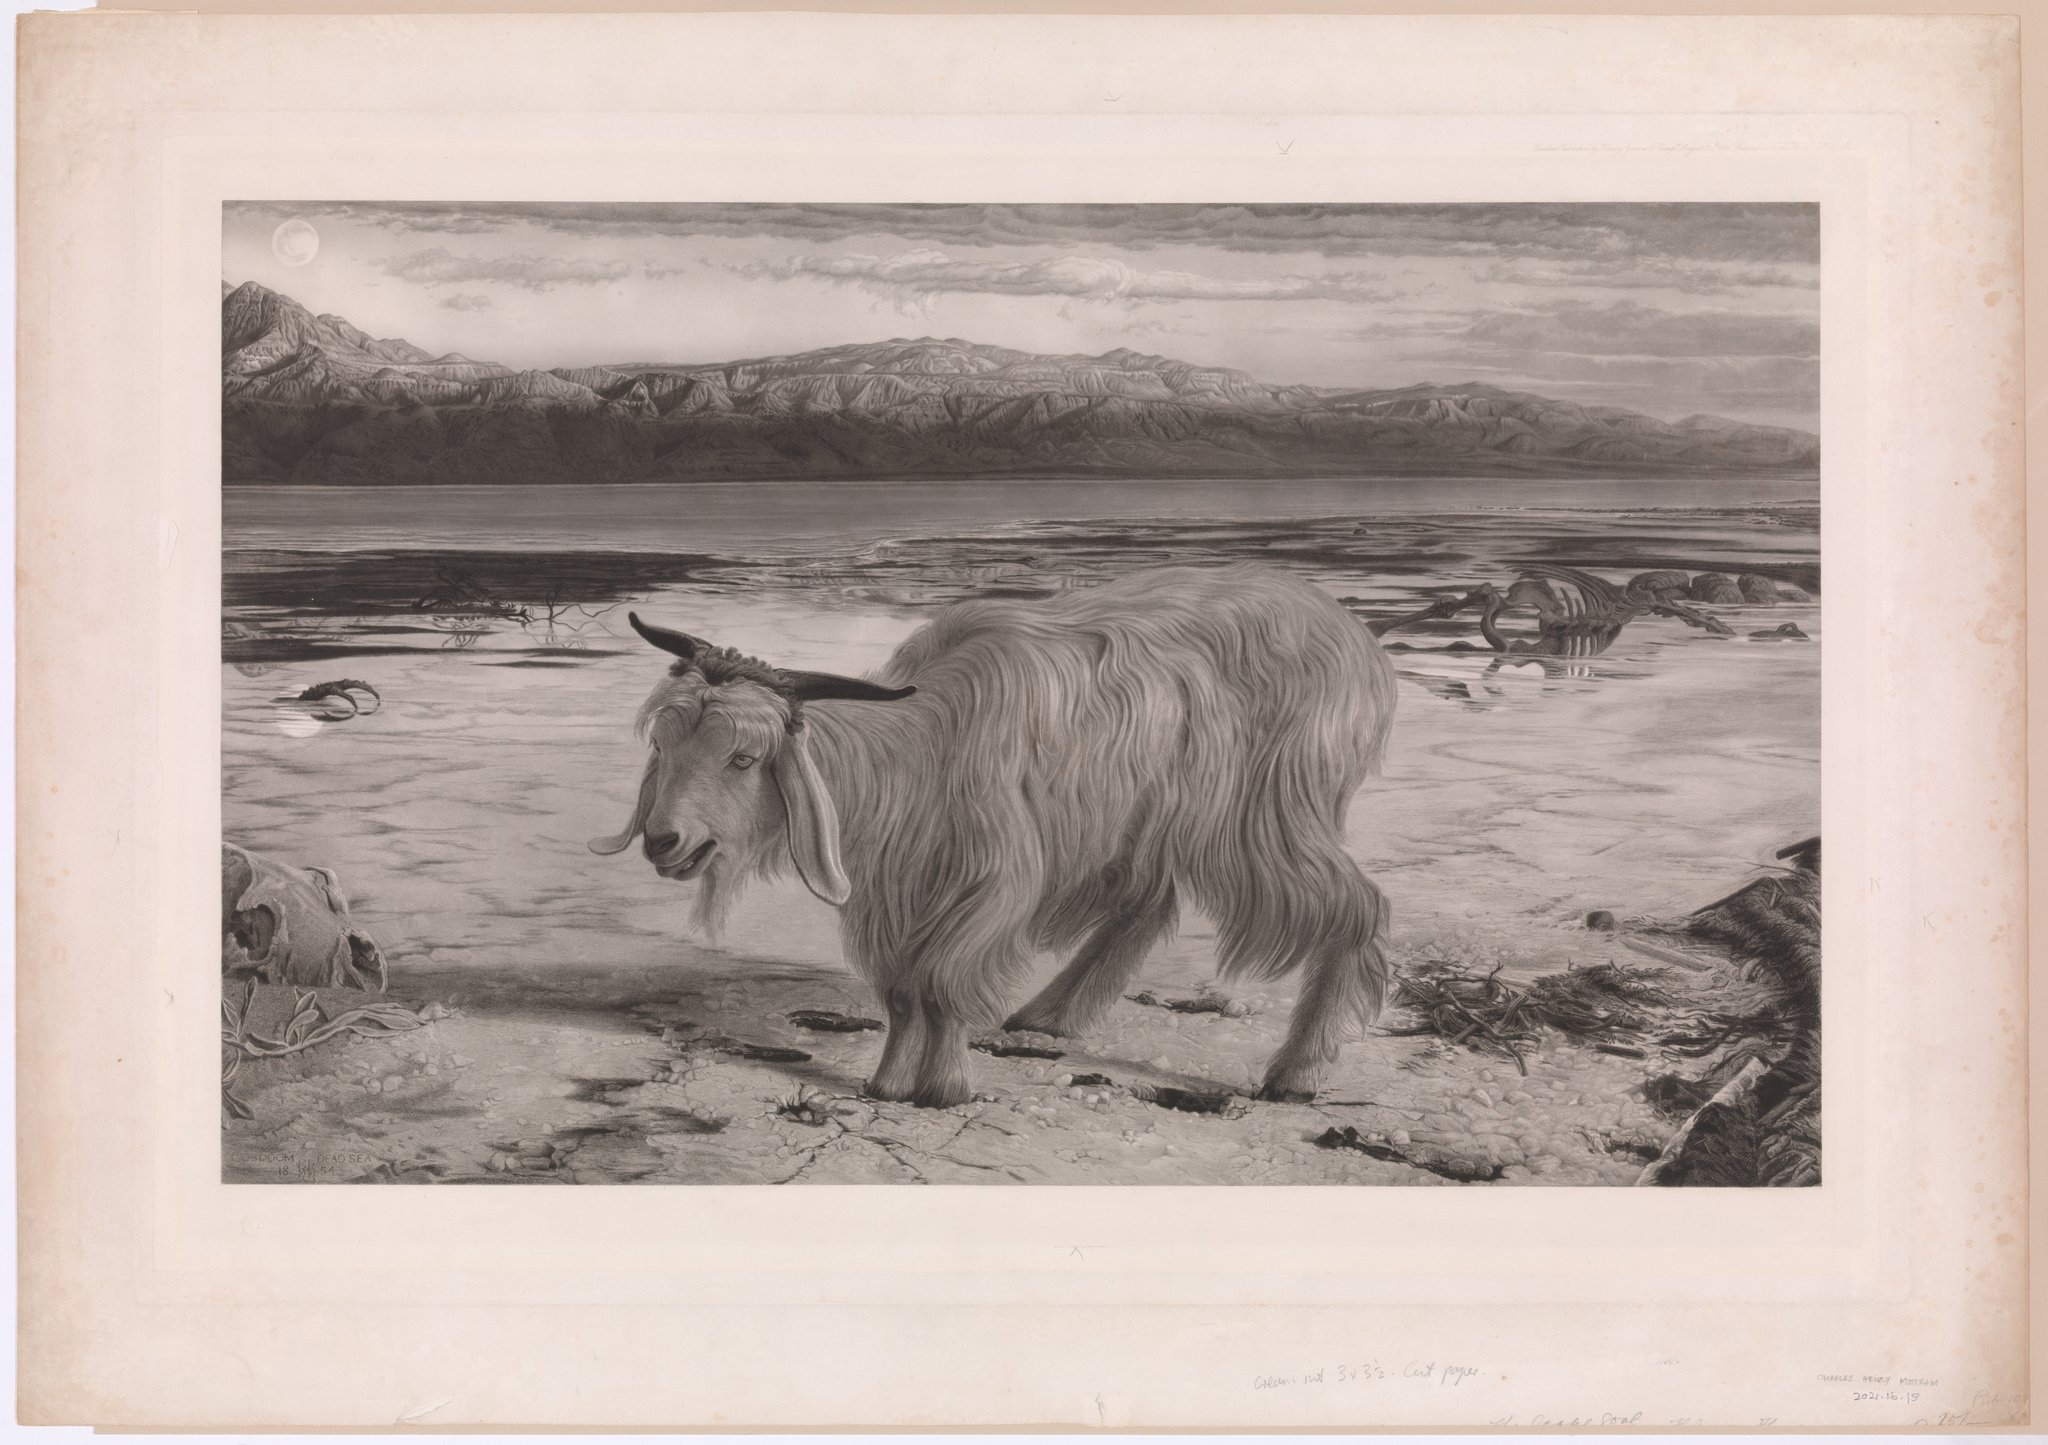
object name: print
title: The Scapegoat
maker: charles henry mottram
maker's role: engraver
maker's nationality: british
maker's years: 1807-1876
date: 1861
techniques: printmaking, engraving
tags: goats